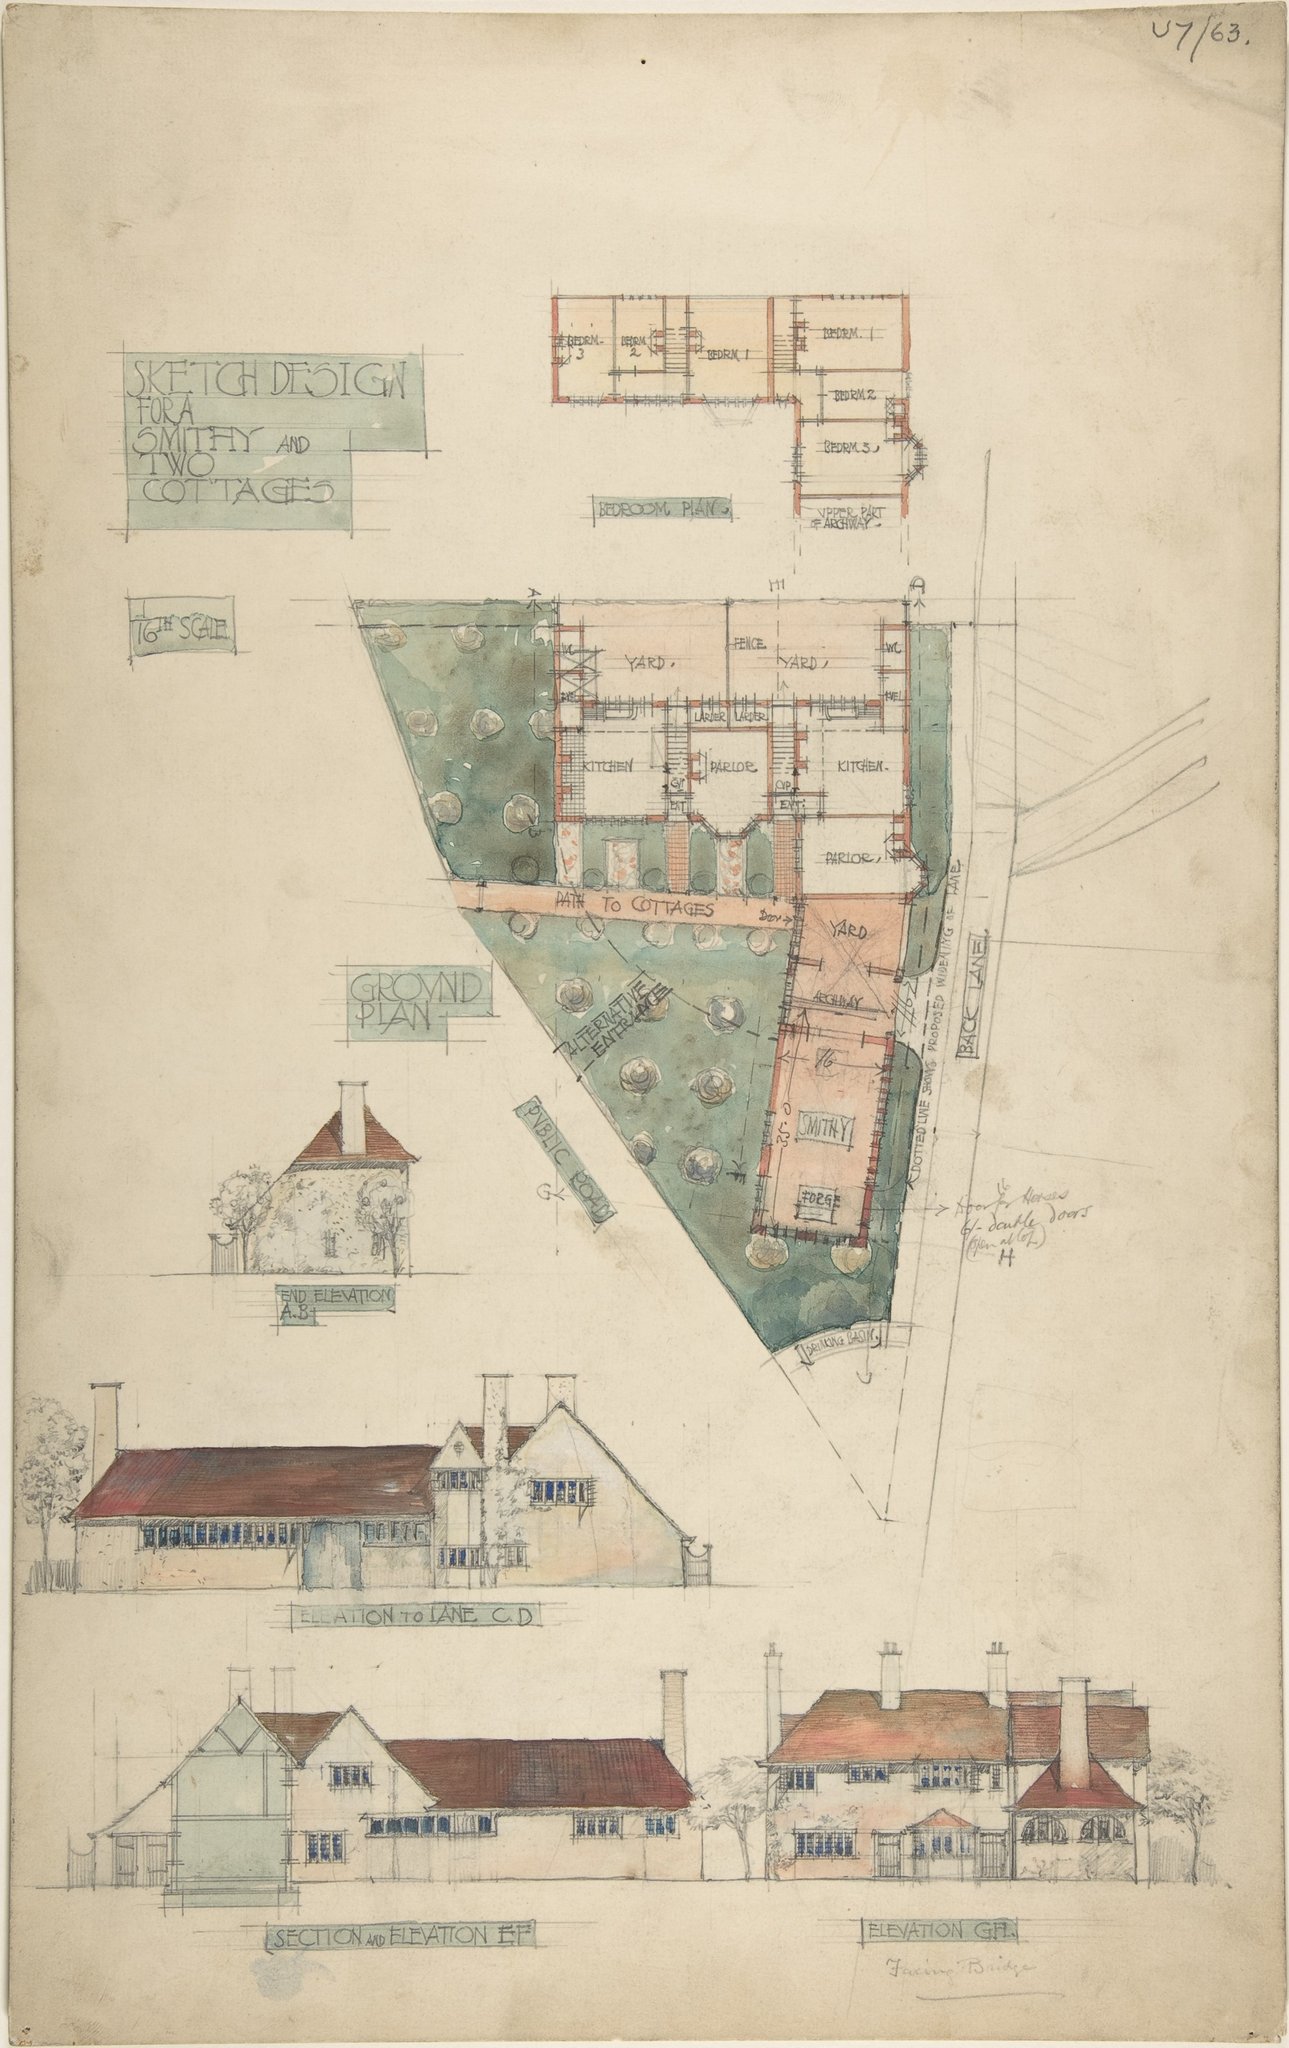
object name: drawing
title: Design for a Smithy and Two Cottages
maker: charles edward mallows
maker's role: artist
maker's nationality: british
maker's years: 1864-1915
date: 1867-1933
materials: graphite, ink, watercolor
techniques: pen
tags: architecture